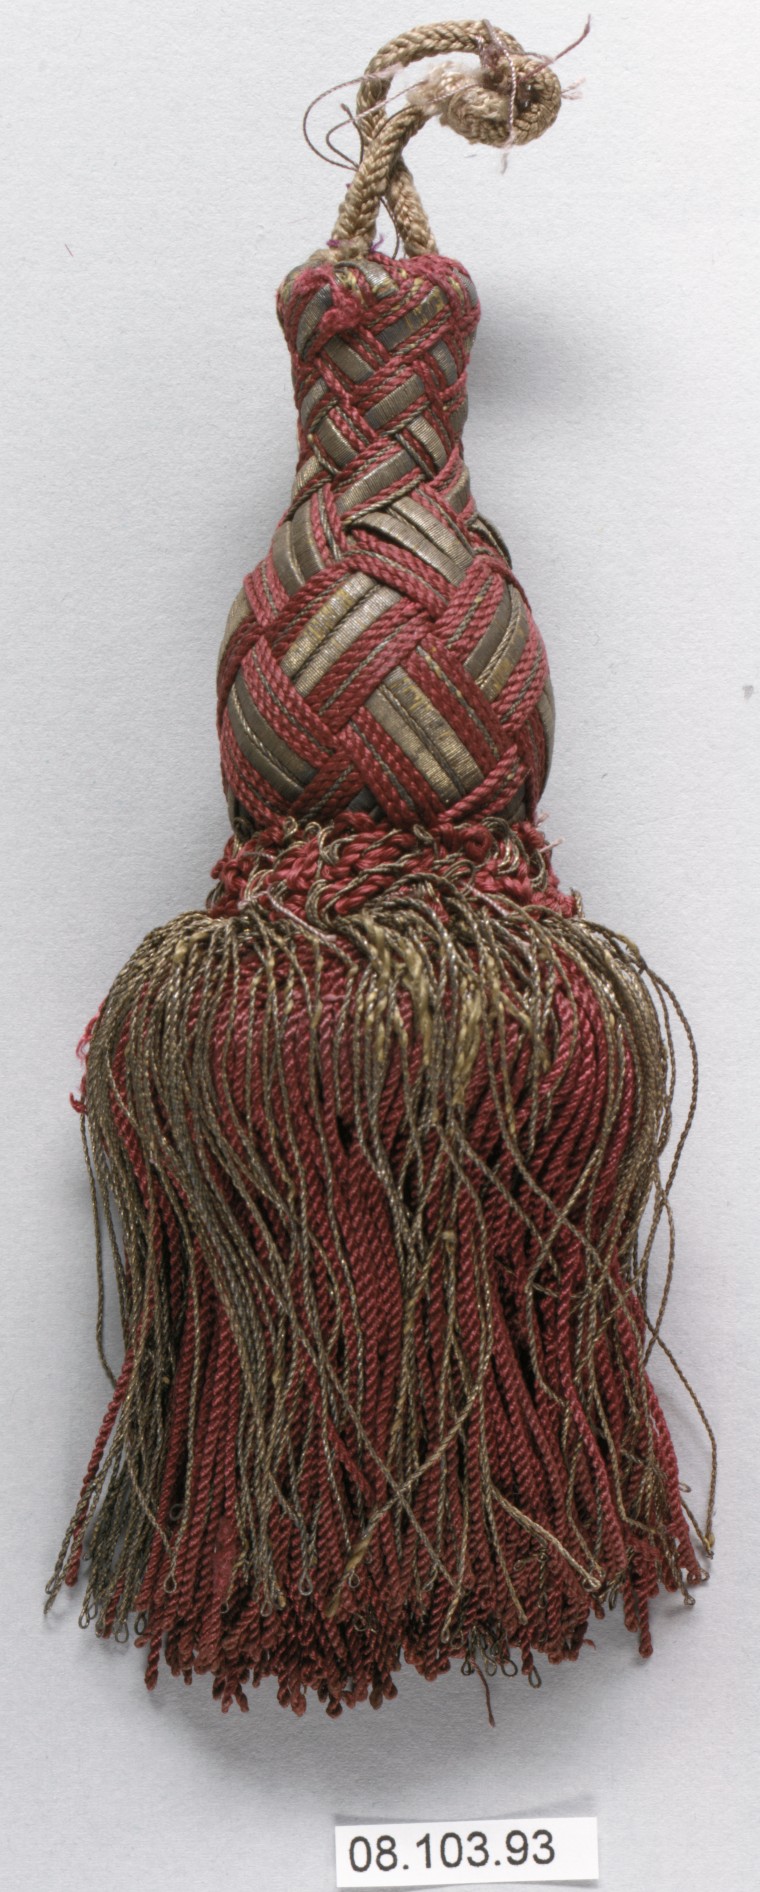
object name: tassel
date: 1767-1800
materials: metal thread, silk